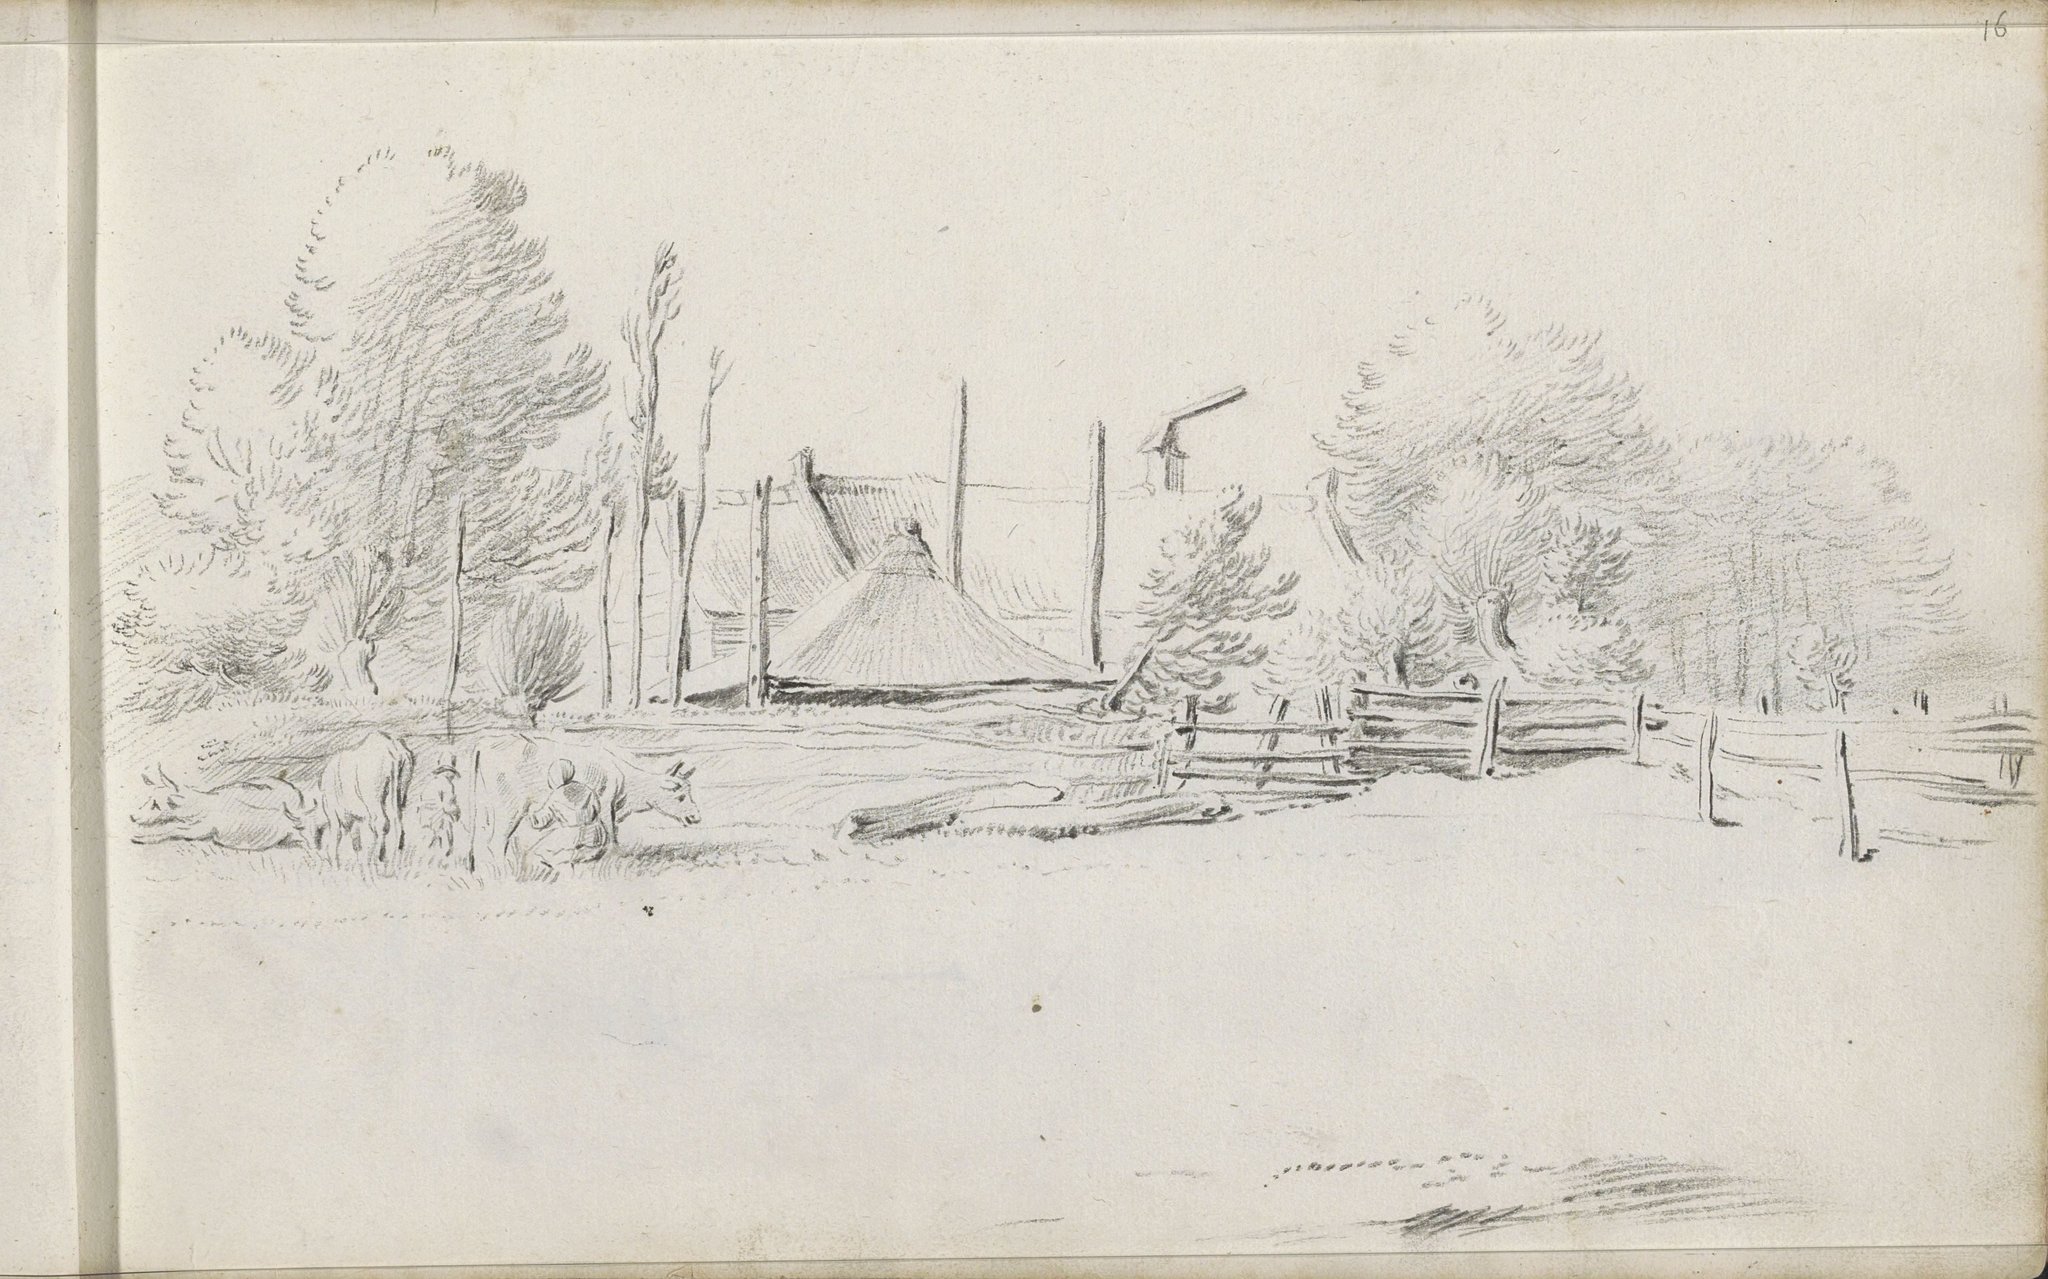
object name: sketchbook leaf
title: Boerderij met een hooimijt en melkende boerin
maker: pieter moninckx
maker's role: draughtsman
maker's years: 1606-1686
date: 1645-1646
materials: chalk, paper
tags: farm (building), milking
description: Blad 16 recto uit een schetsboek met 39 bladen.